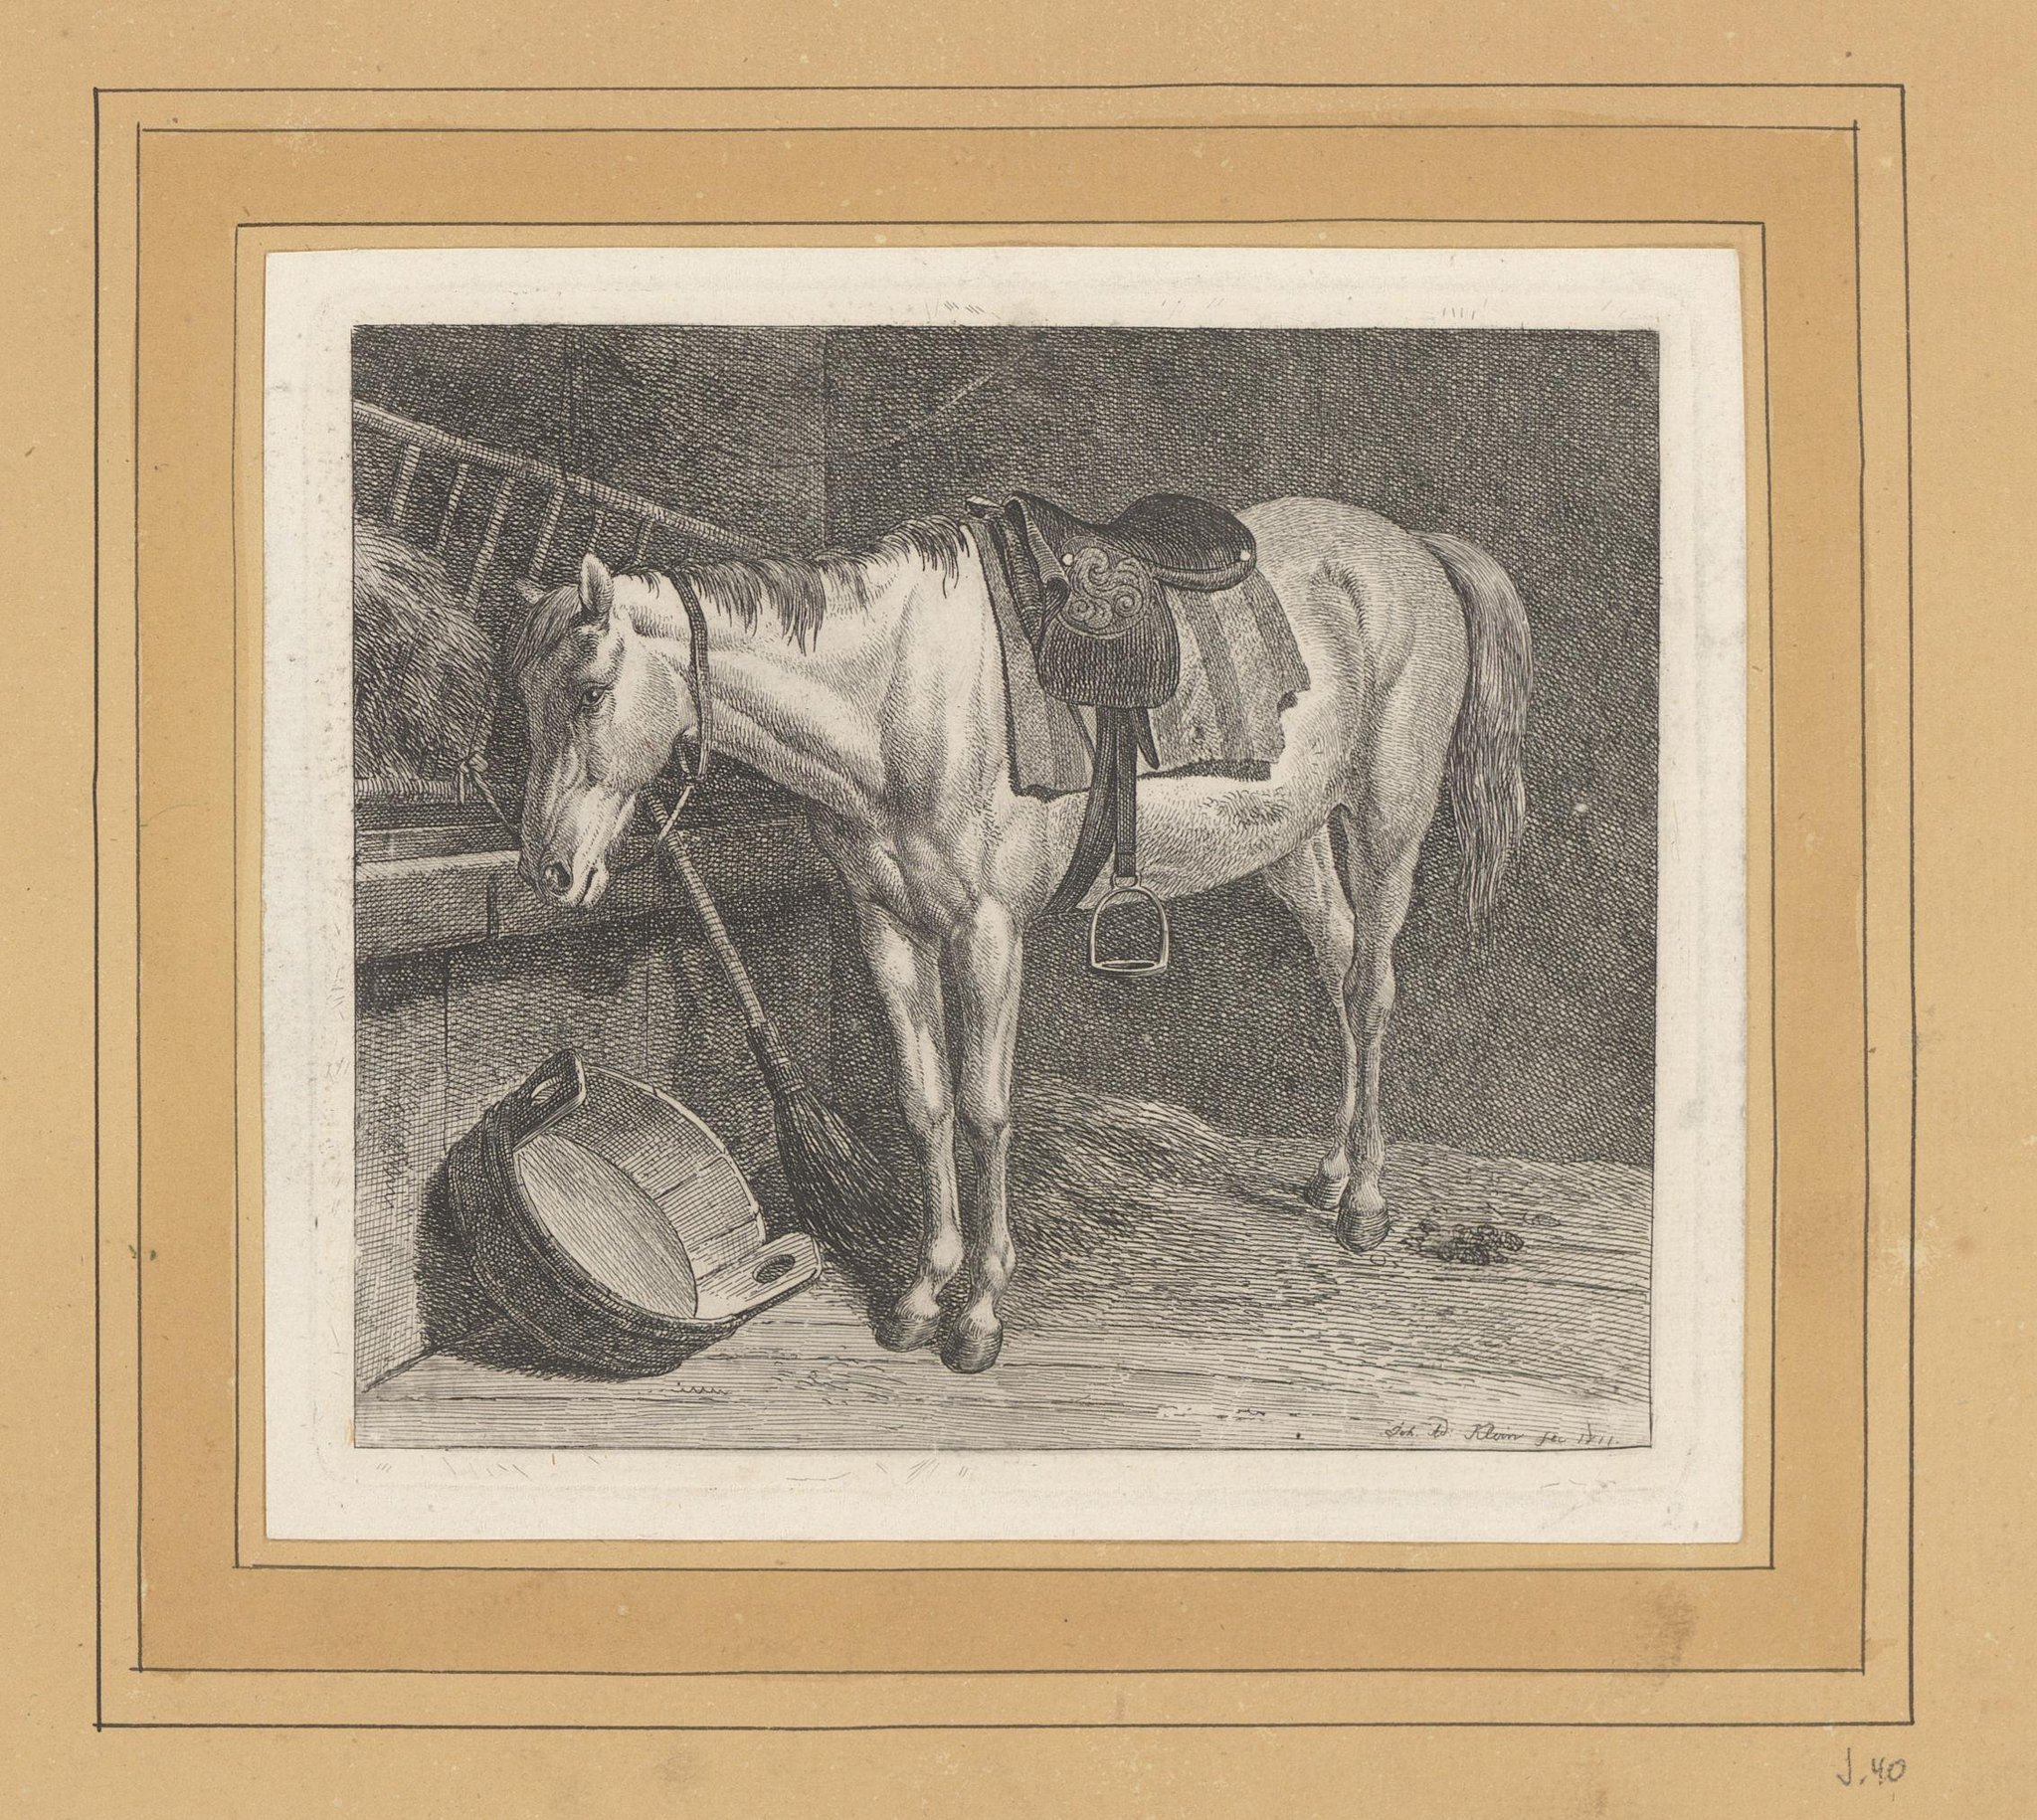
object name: album leaf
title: Paard in een stal aangelijnd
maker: johann adam klein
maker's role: draughtsman, print maker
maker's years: 1792-1875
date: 1811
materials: paper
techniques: etching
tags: barn, saddle, horse, shrubs: broom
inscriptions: collector's mark: Lugt 2760, collector's mark: Lugt 2228